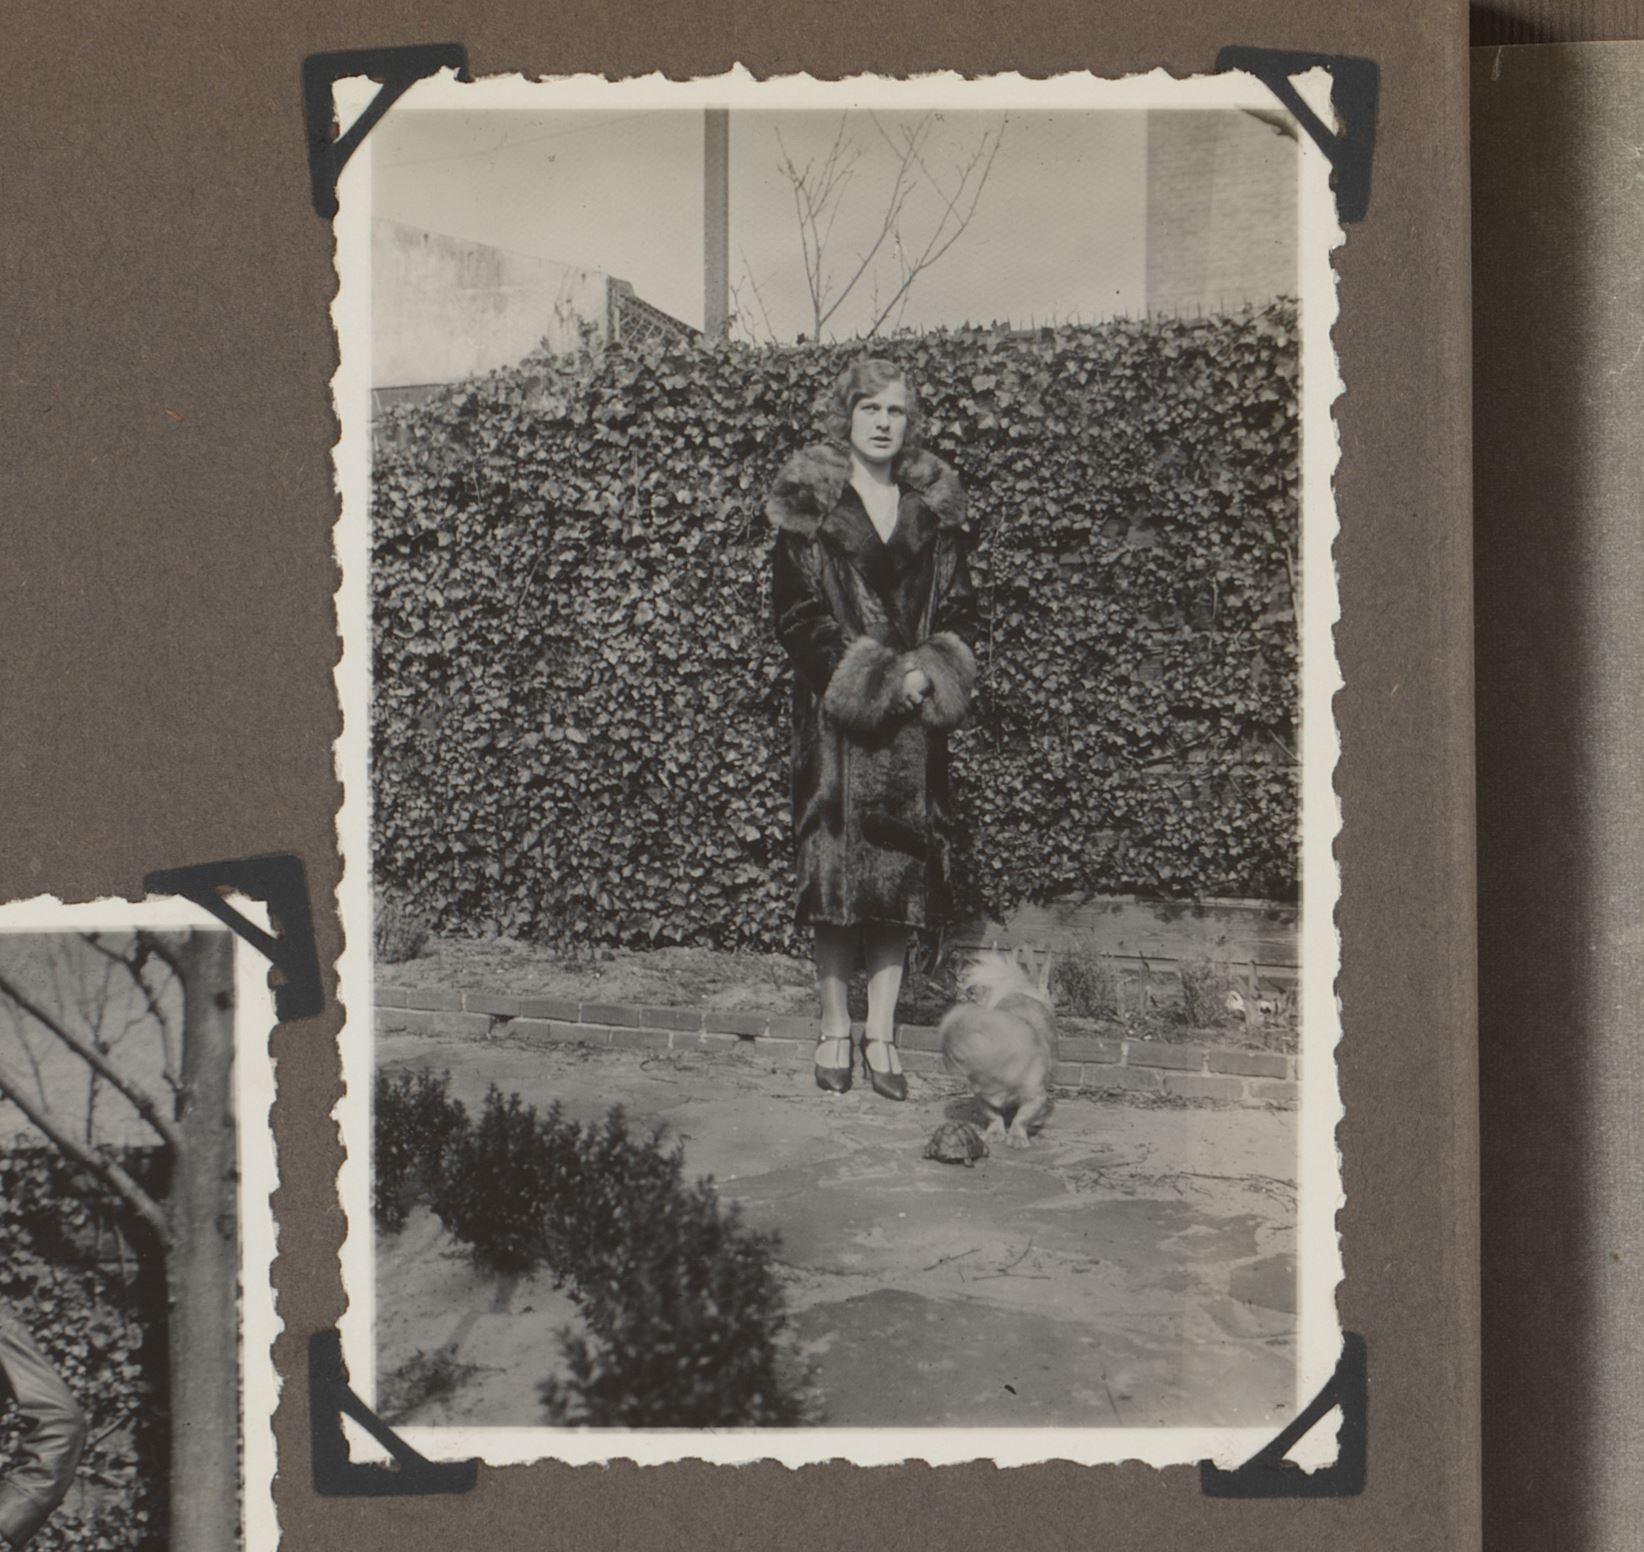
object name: album leaf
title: Portret van Corry Mak van Waay-Zulver met een hond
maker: Anonymous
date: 1930-1935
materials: paper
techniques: gelatin silver print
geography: netherlands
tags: historical persons - bb - woman, dog, netherlands